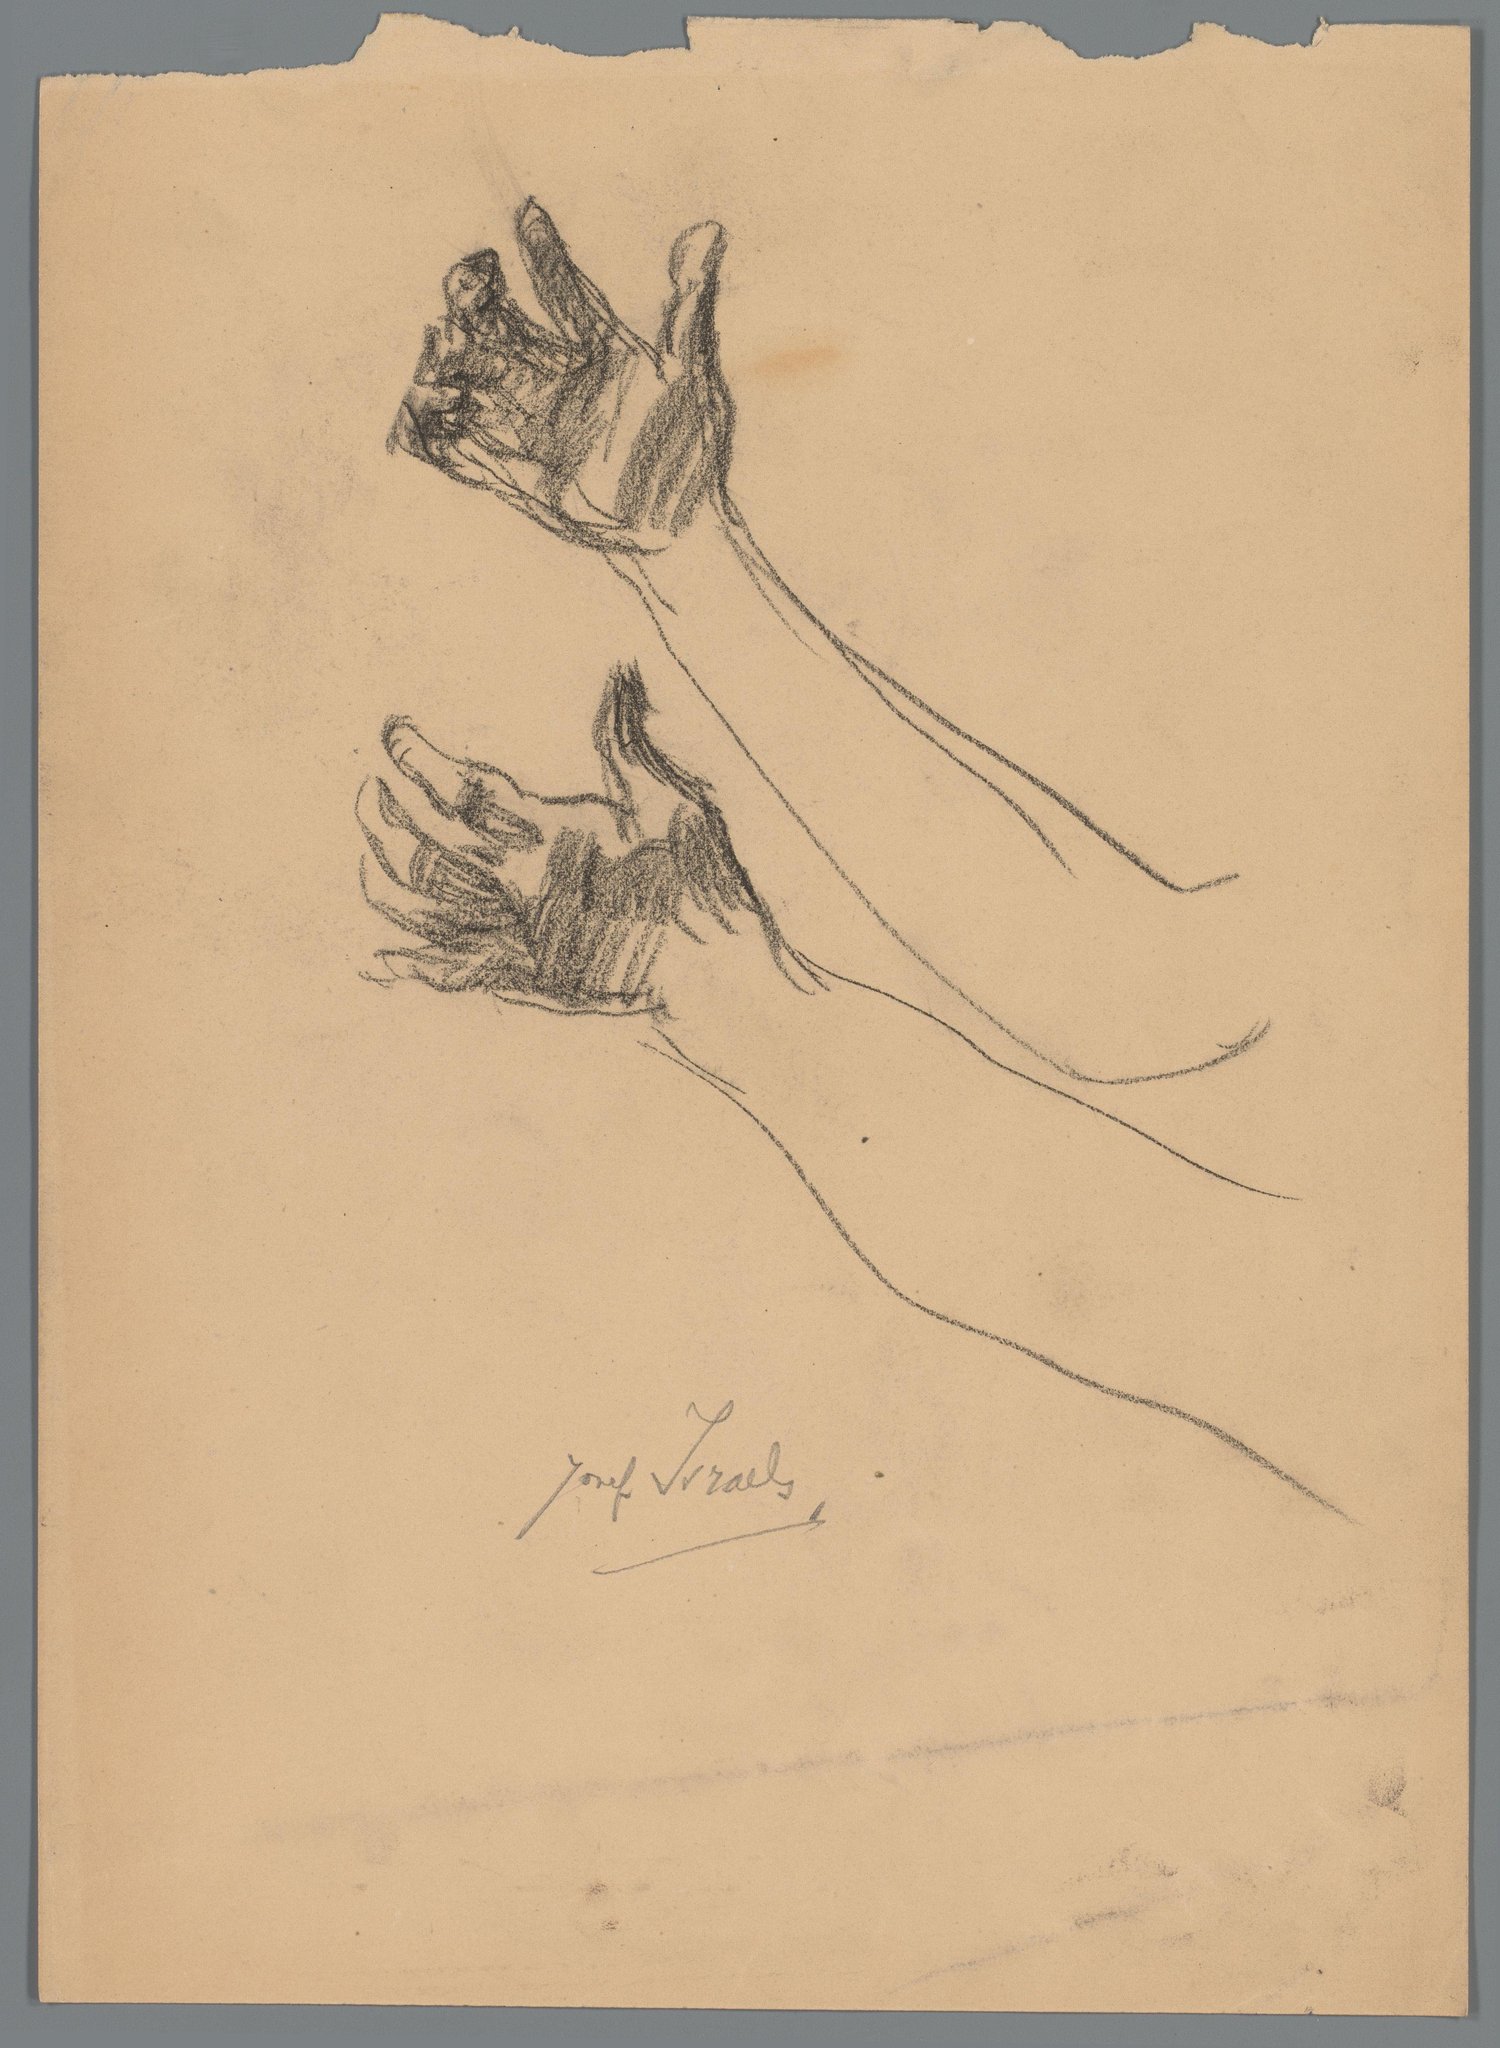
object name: drawing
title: Opgeheven handen van David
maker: jozef israëls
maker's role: draughtsman, painter, print maker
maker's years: 1824-1911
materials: chalk, paper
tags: hand, story of david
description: Voorstudie voor het schilderij 'David en Saul' dat zich in het Groninger Museum bevindt.